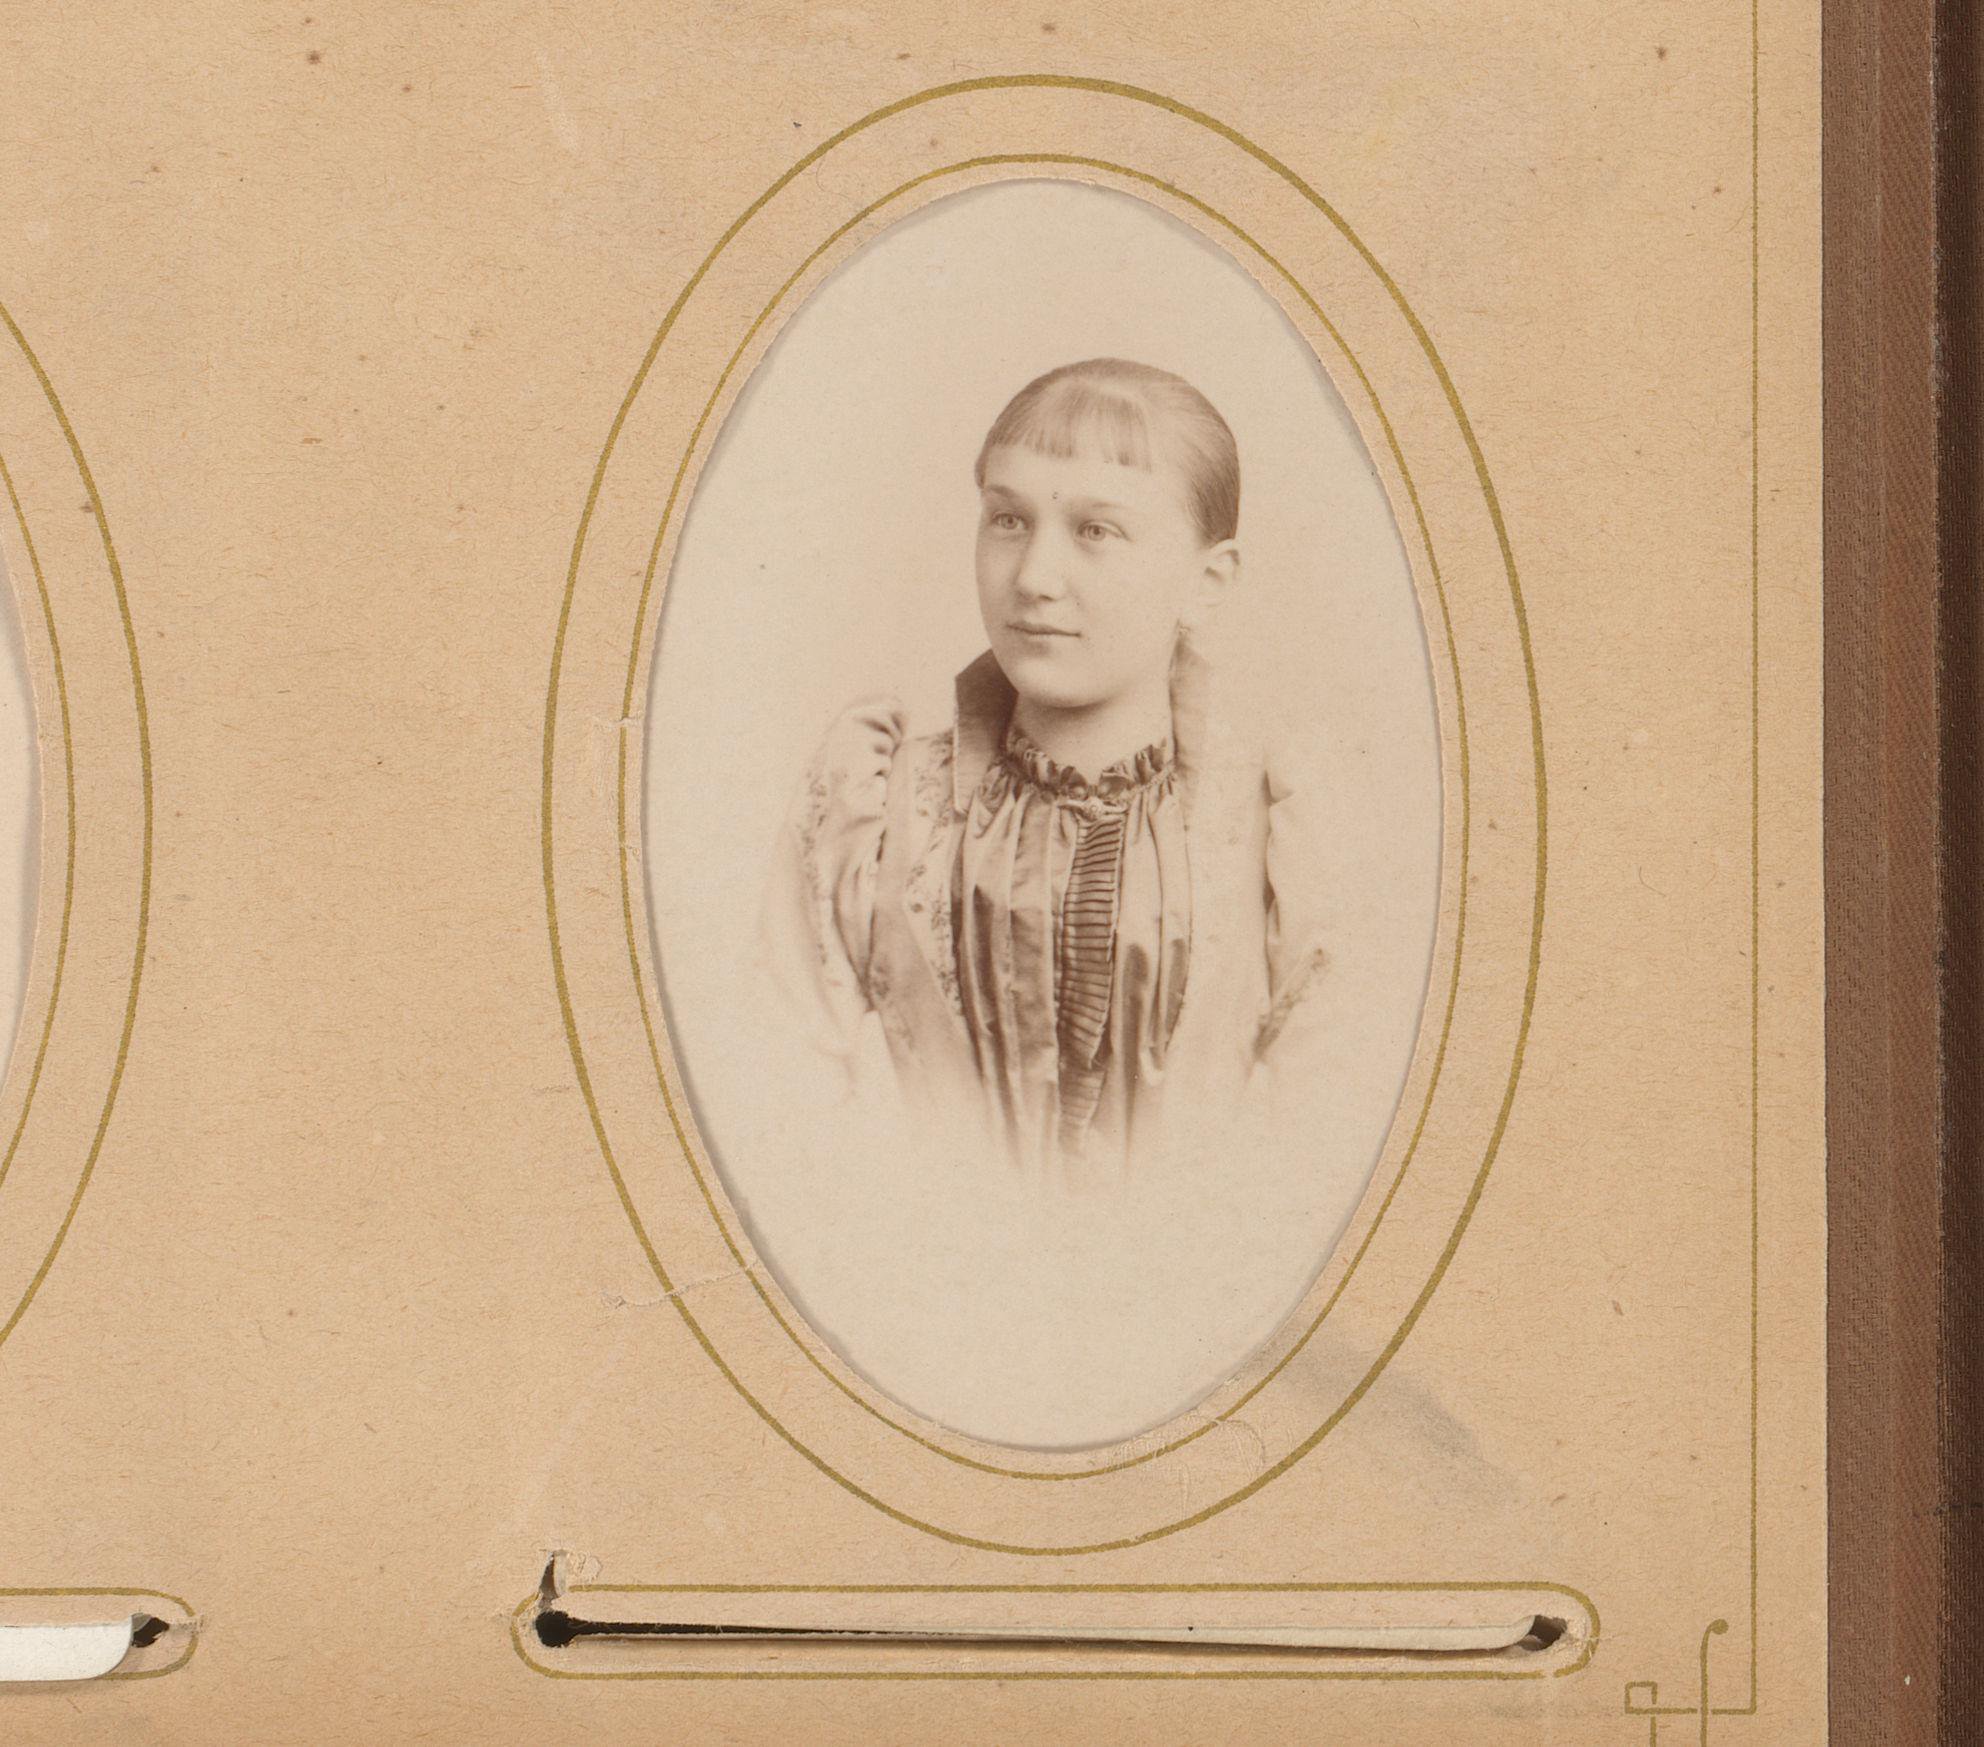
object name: album leaf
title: Portret van een jonge vrouw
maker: gustav andré jr.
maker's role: fotograaf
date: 1860-1900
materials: cardboard, photographic support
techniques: albumen print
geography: potsdam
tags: adolescent, young woman, maiden, historical persons - bb - woman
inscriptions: inscription: ‘Gustav André jr/ Potsdam/ Spandauer-Str 34.’